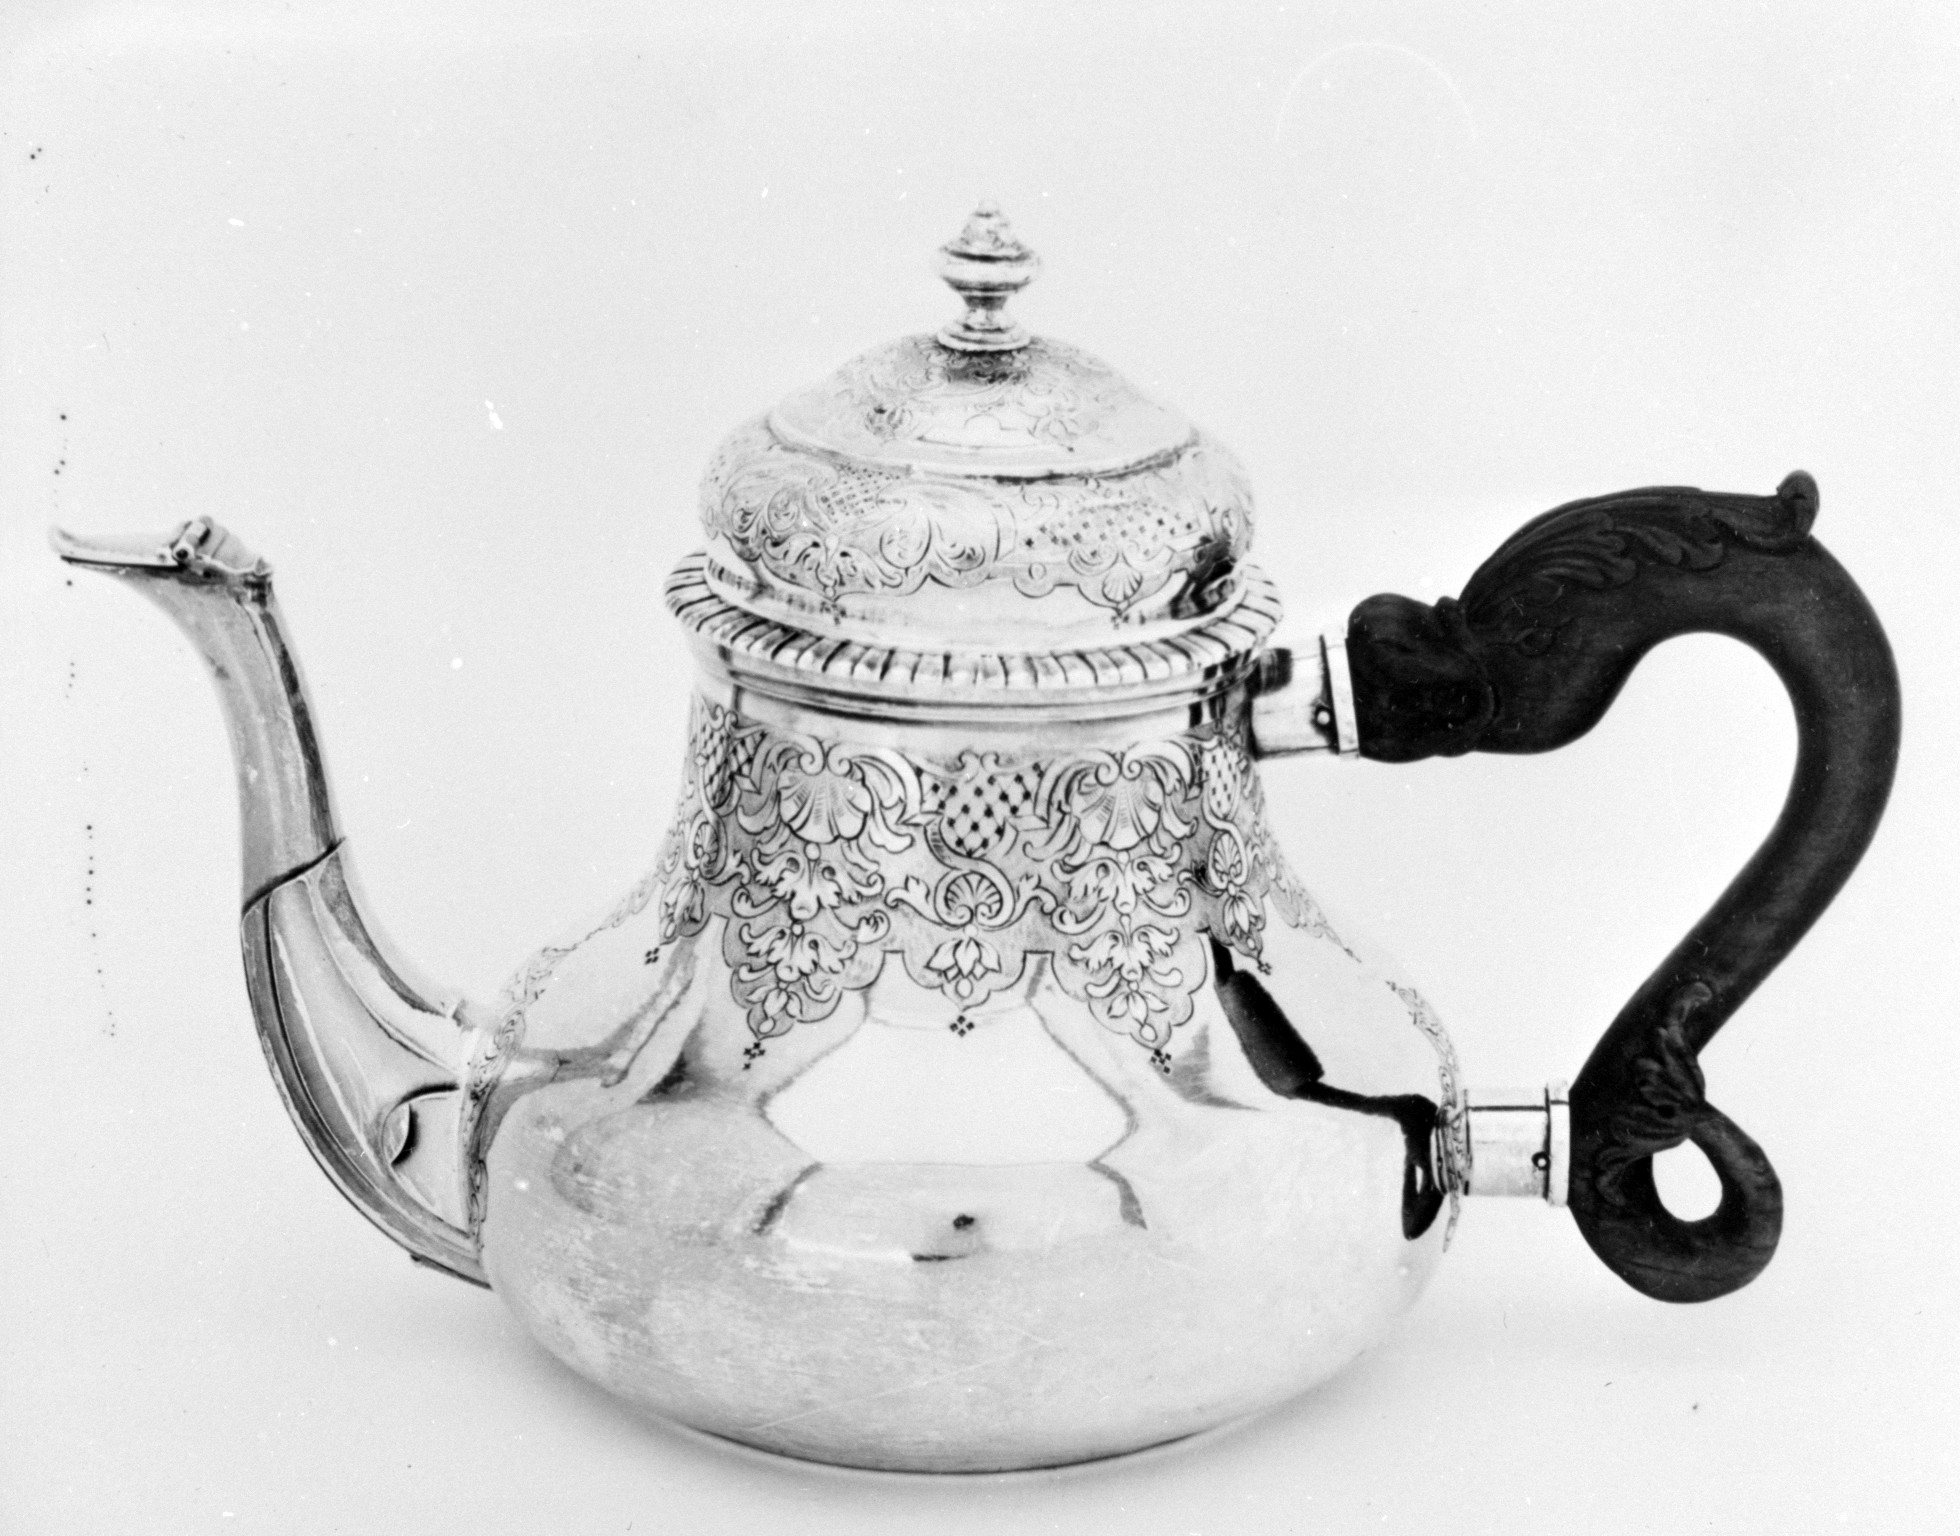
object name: teapot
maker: andreas braun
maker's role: maker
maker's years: 1697-1787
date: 1725-1740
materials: silver, wood